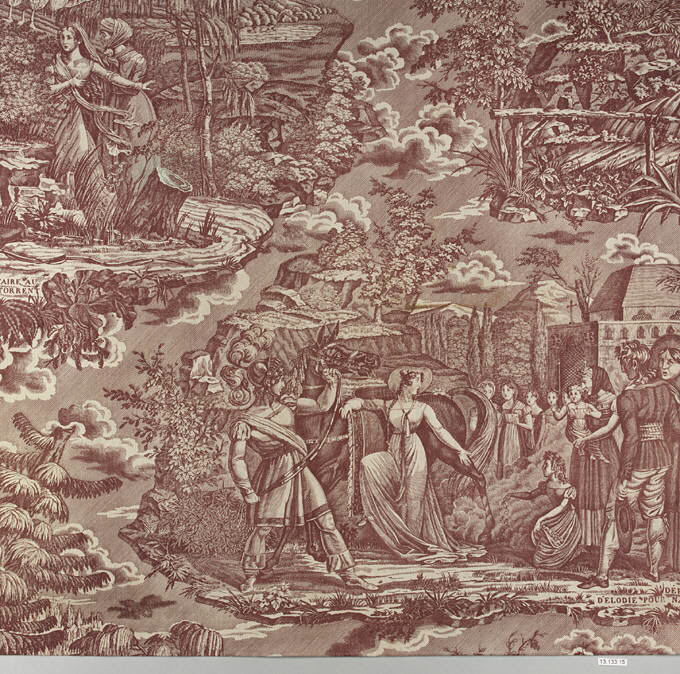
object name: furnishing textile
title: Scenes from "Le Solitaire"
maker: marius rollet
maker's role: engraver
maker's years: 1775-1875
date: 1822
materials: cotton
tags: men,women,horses